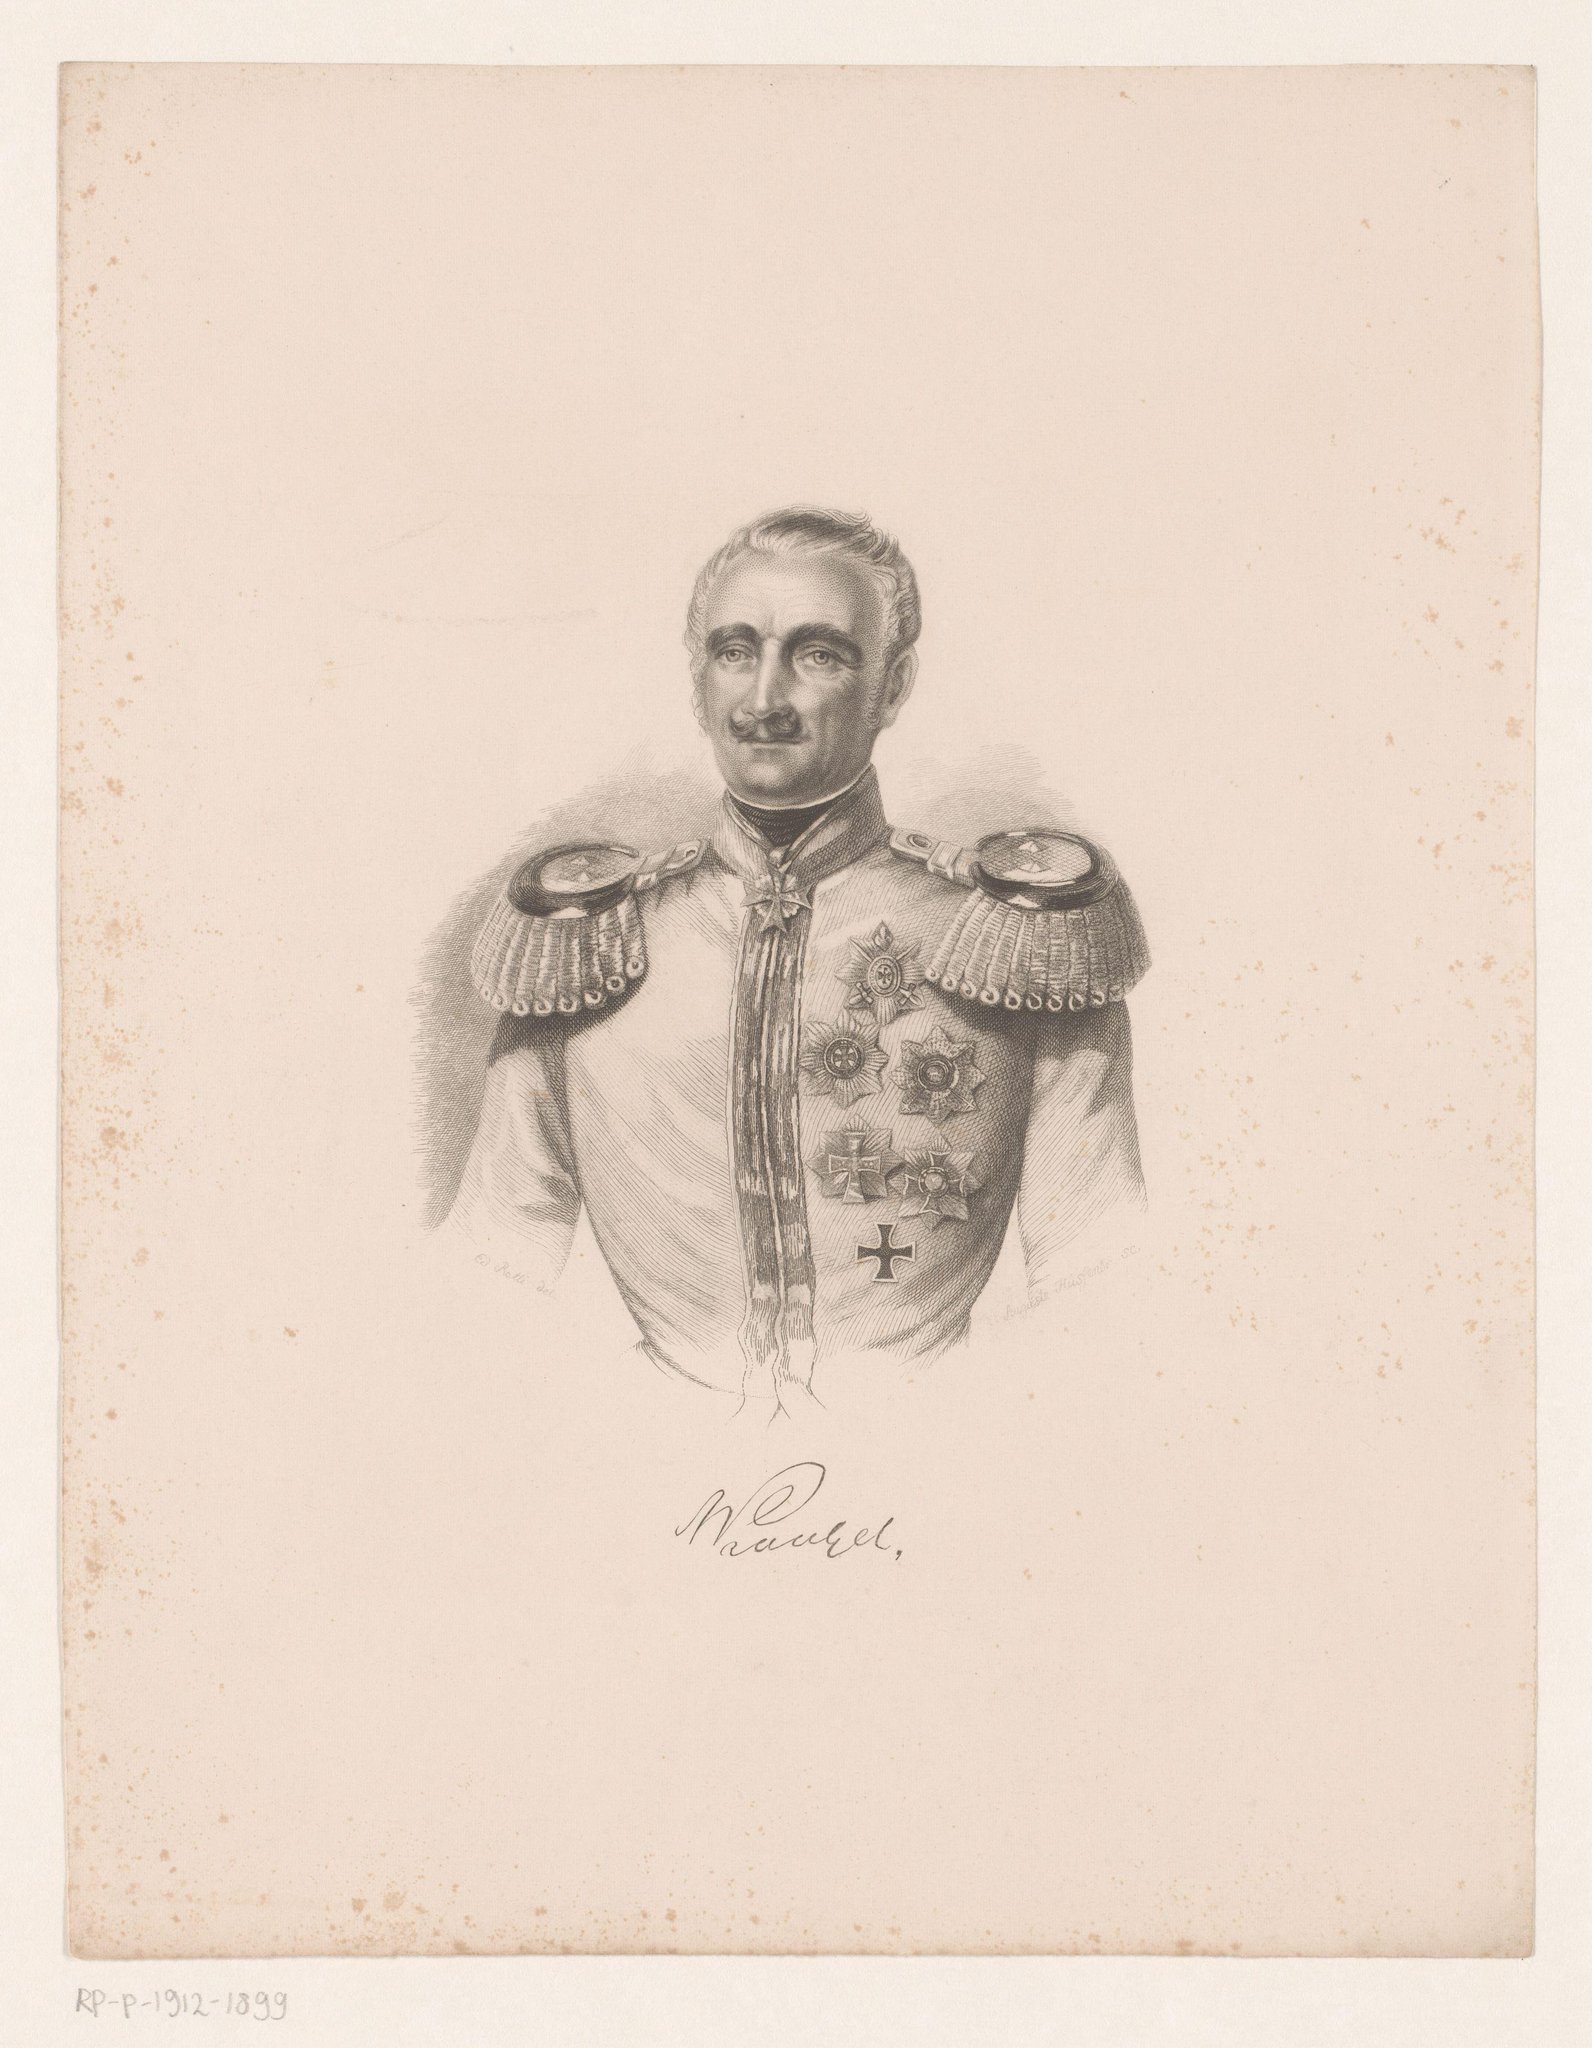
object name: print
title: Portret van Friedrich Wrangel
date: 1826-1877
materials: paper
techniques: engraving, etching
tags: knighthood order: teutonic order - insignia of a knighthood order, e.g.: badge, chain (with name of order), knighthood order (with name) - insignia of a knighthood order, e.g.: badge, chain (with name of order), commander-in-chief, general, marshal, historical persons, knighthood order of the golden fleece - insignia of a knighthood order, e.g.: badge, chain (with name of order)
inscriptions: collector's mark: Lugt 2228